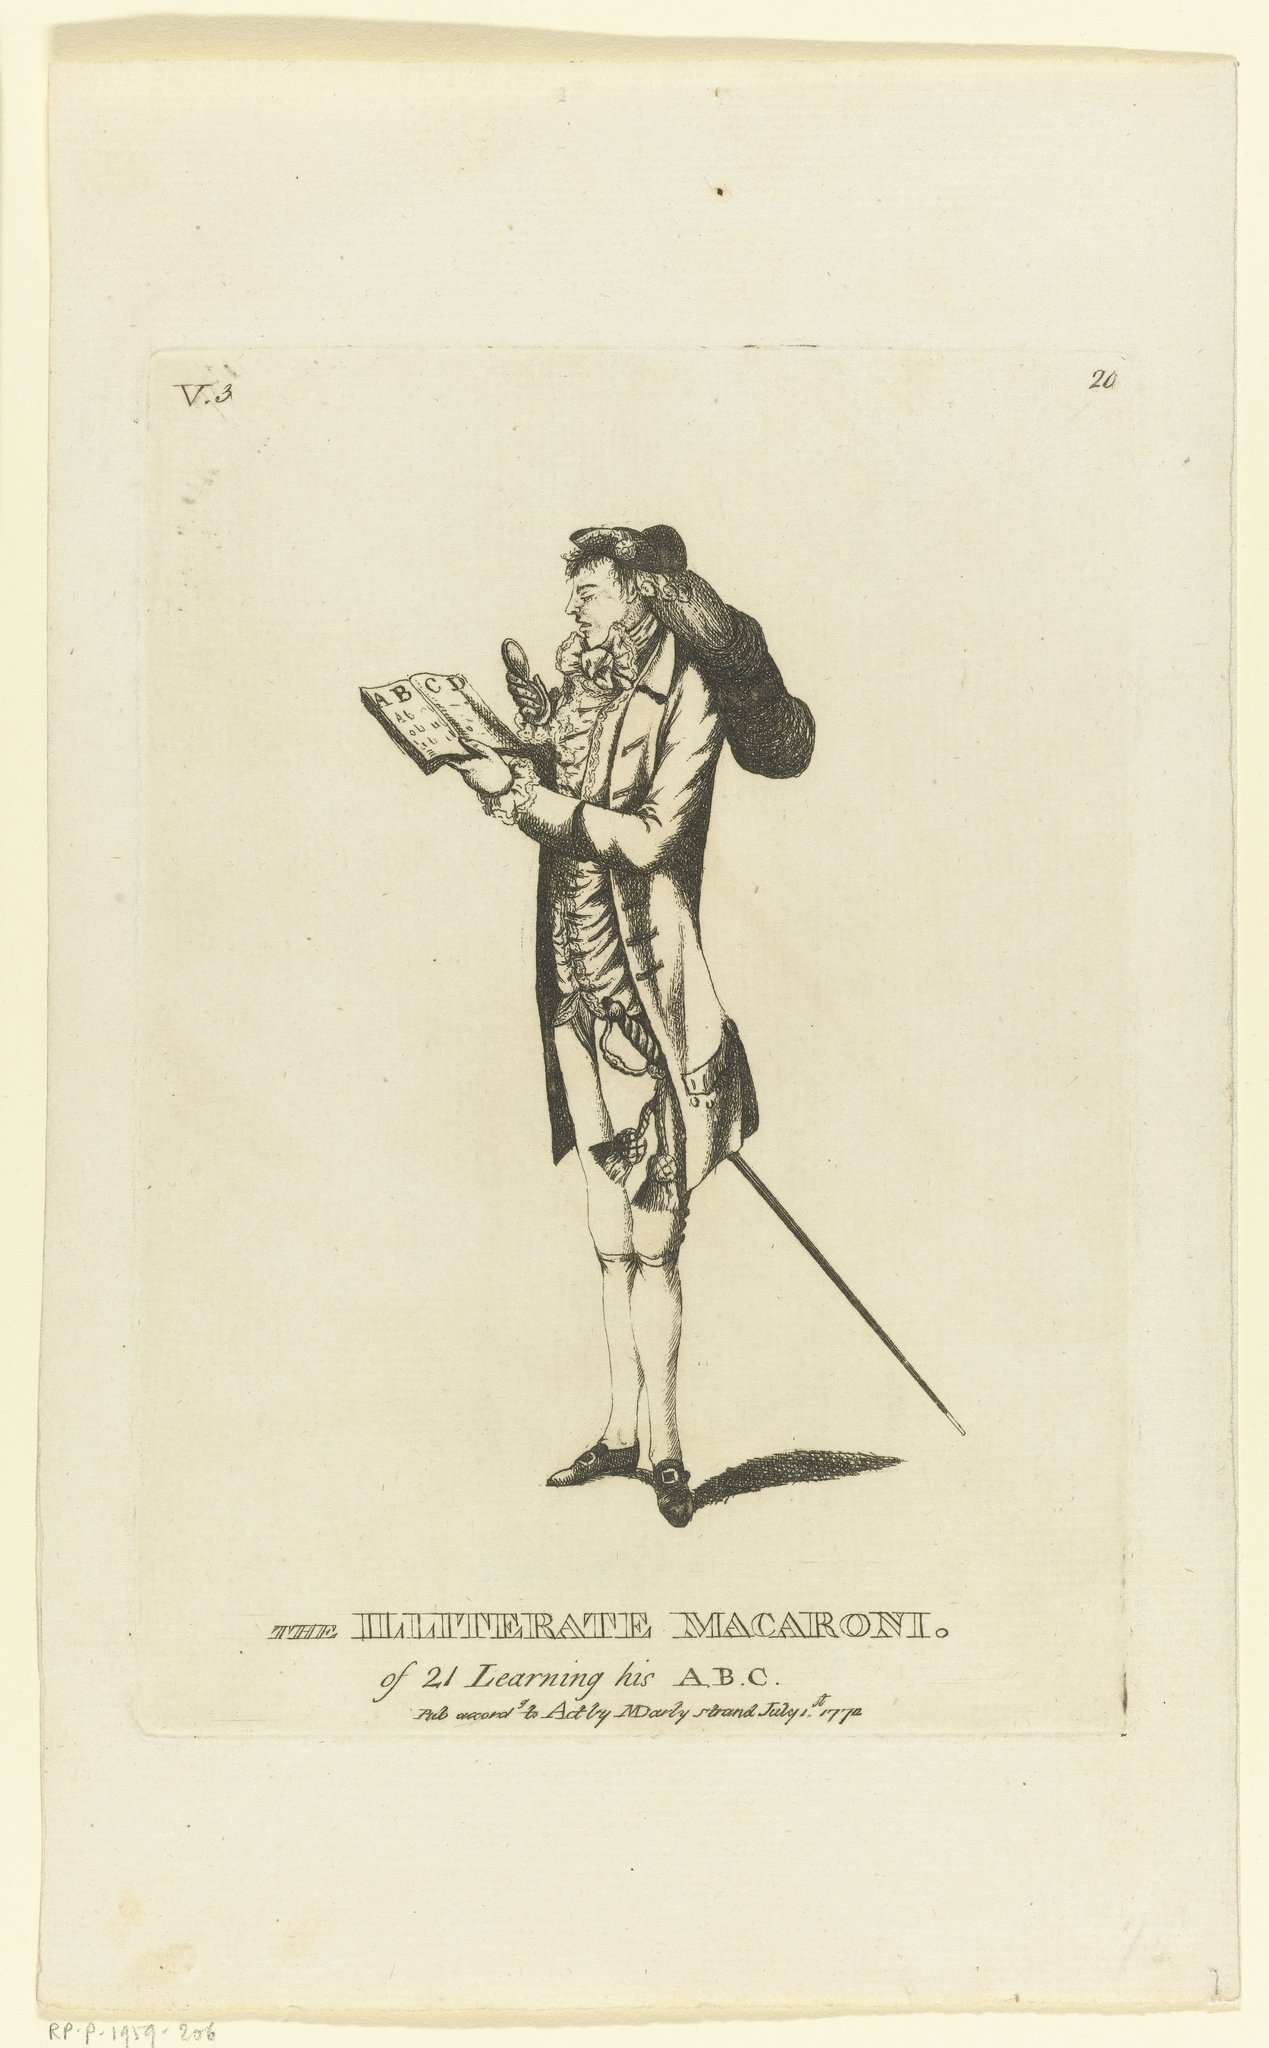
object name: costume print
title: Macaronies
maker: matthew darly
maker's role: print maker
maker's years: 1720-1780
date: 1772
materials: paper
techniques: etching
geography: london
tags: clothing for the upper part of the body (vest) (+ men's clothes), dandy, beau, monocle, single lorgnette, hacking and thrusting weapons, coat (+ men's clothes), head-gear: hat (+ men's clothes), styles of hairdress, shoes, sandals (+ men's clothes), trousers, breeches, etc. (breeches) (+ men's clothes)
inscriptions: title: ‘THE LITERATE MACARONI. / of 21 Learning his A.B.C. / Pub accord g to Act by MDarly strand July 1 st 1772.’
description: Een jongeman bestudeert met een vergrootglas een ABC-boek. Hij draagt een pruik met grote haarzak, een frak met vest en hoog gestrikte halsdoek. Degen langs de rechterzijde. Linksboven V. 3; rechtsboven nummer 20. Engelse karikaturen uit de serie 'Macaronies' uitgegeven door D. Marly in 1771 en 1772.